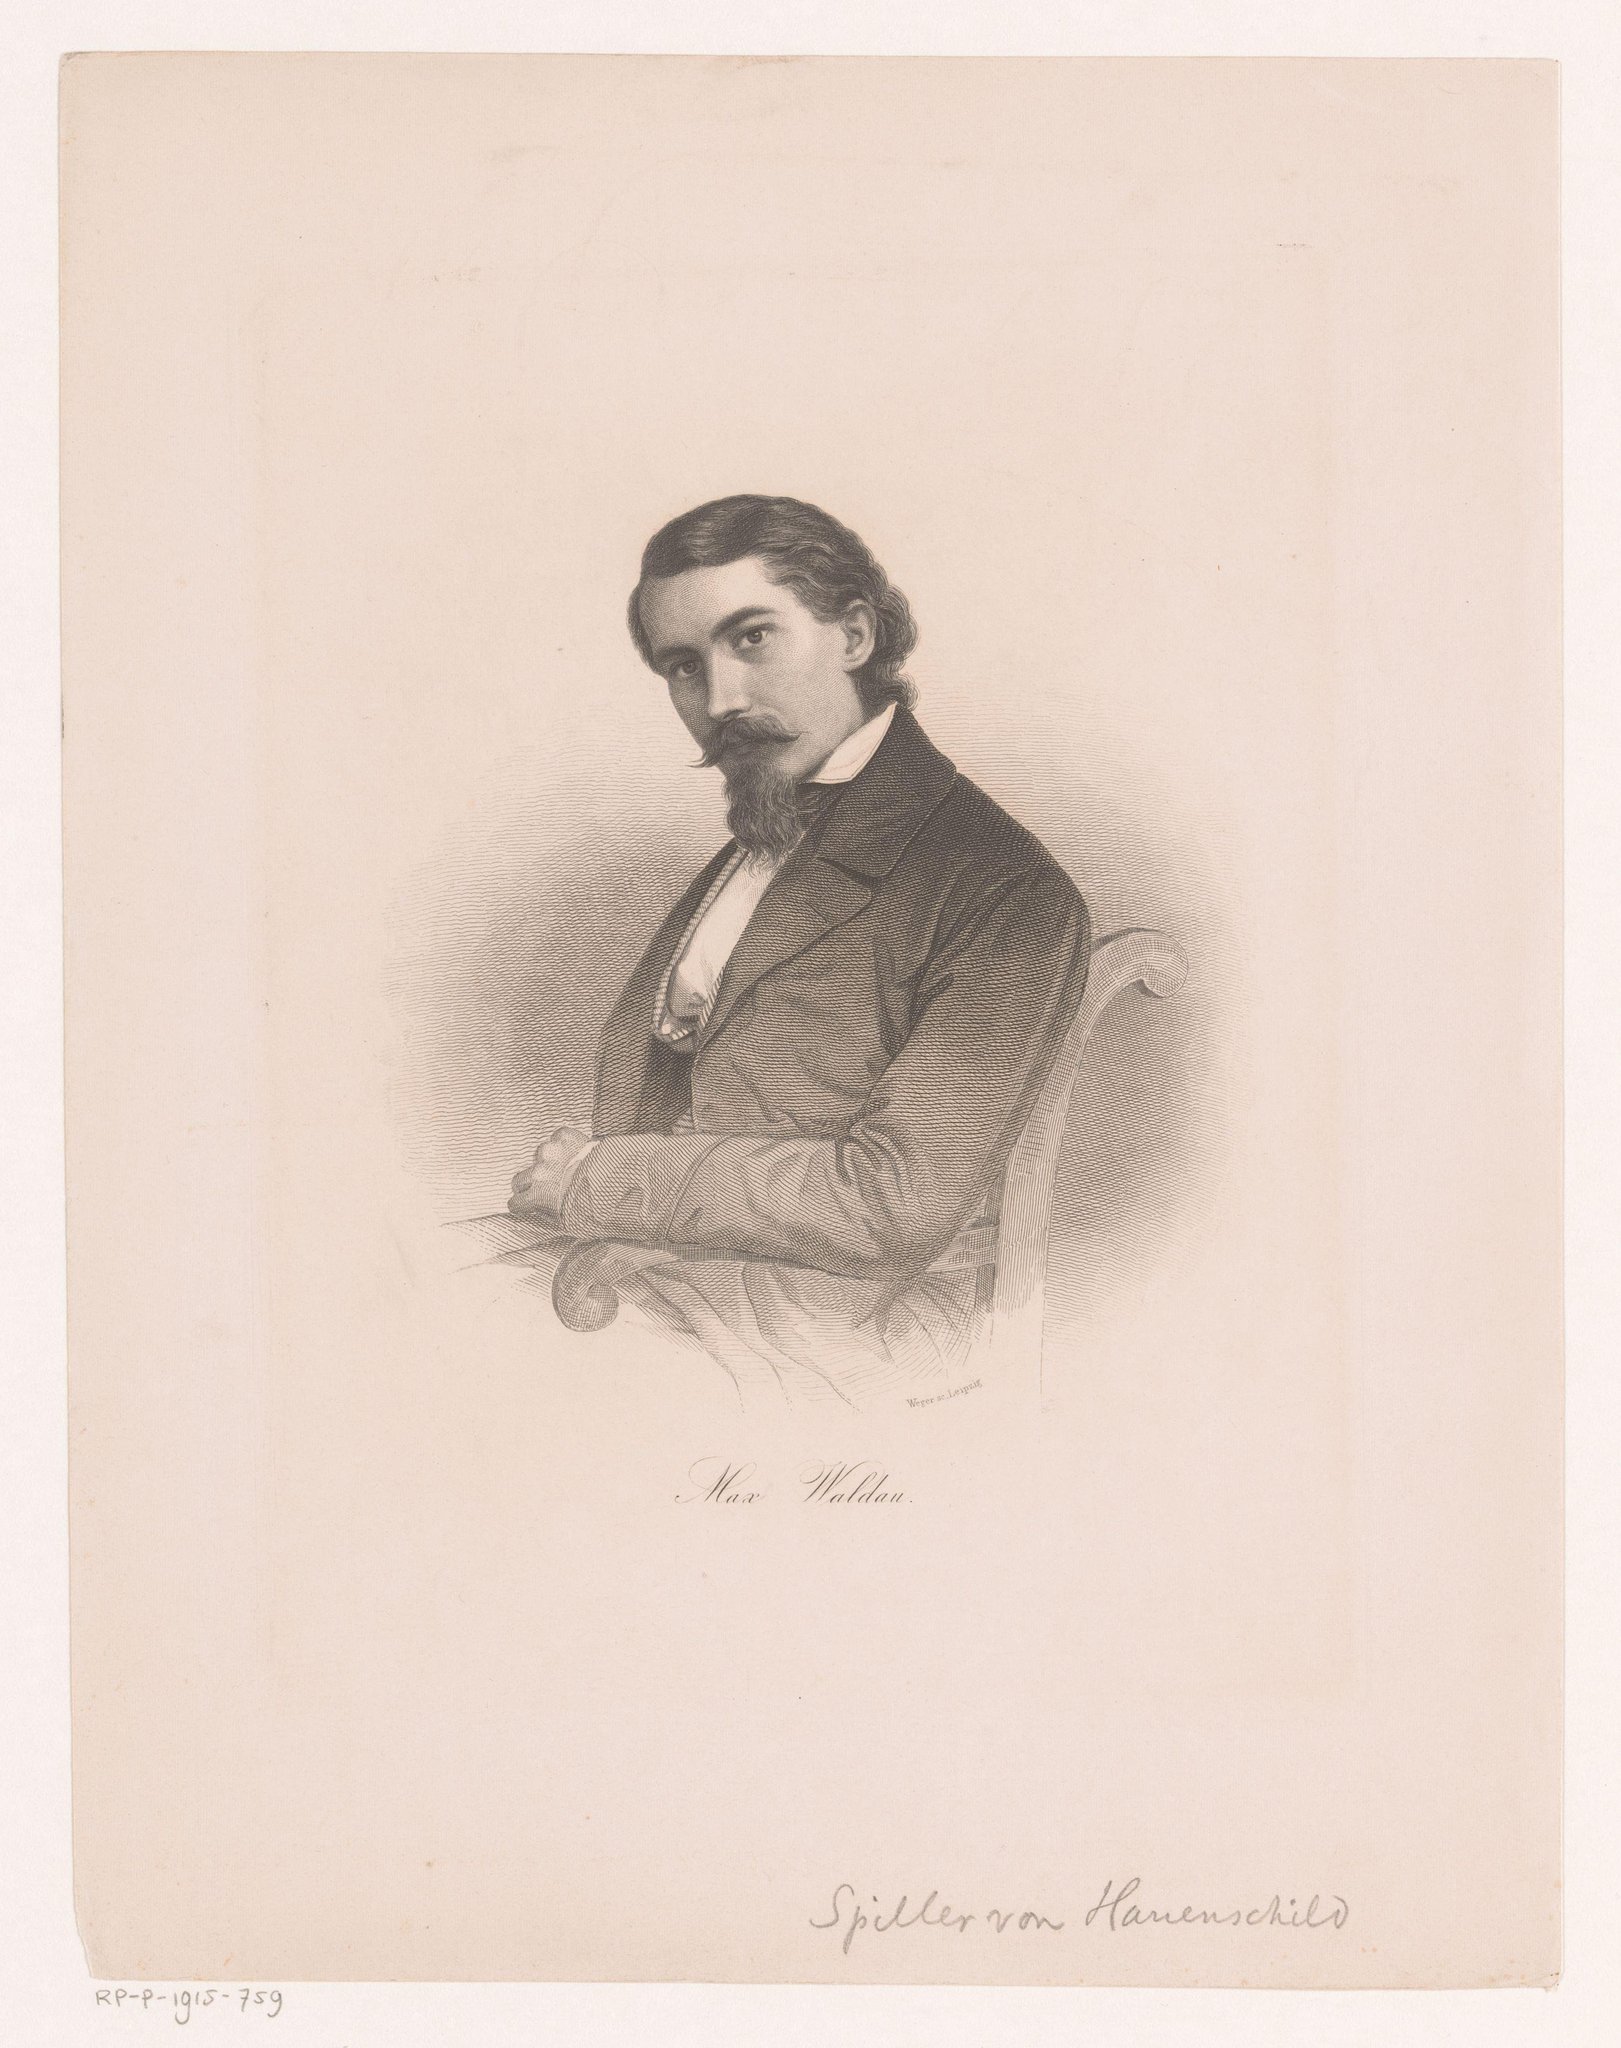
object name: print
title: Portret van Max Waldau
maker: august weger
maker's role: print maker, printer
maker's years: 1823-1892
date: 1855-1892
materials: paper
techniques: engraving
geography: leipzig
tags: poland, historical persons, portrait of a writer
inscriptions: collector's mark: Lugt 2228